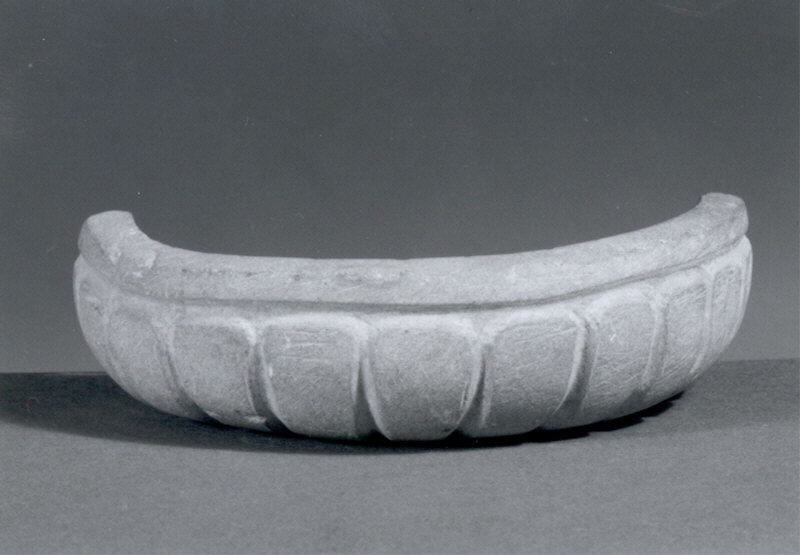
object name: bowl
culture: iranian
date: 900-801 BCE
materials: stone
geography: iran